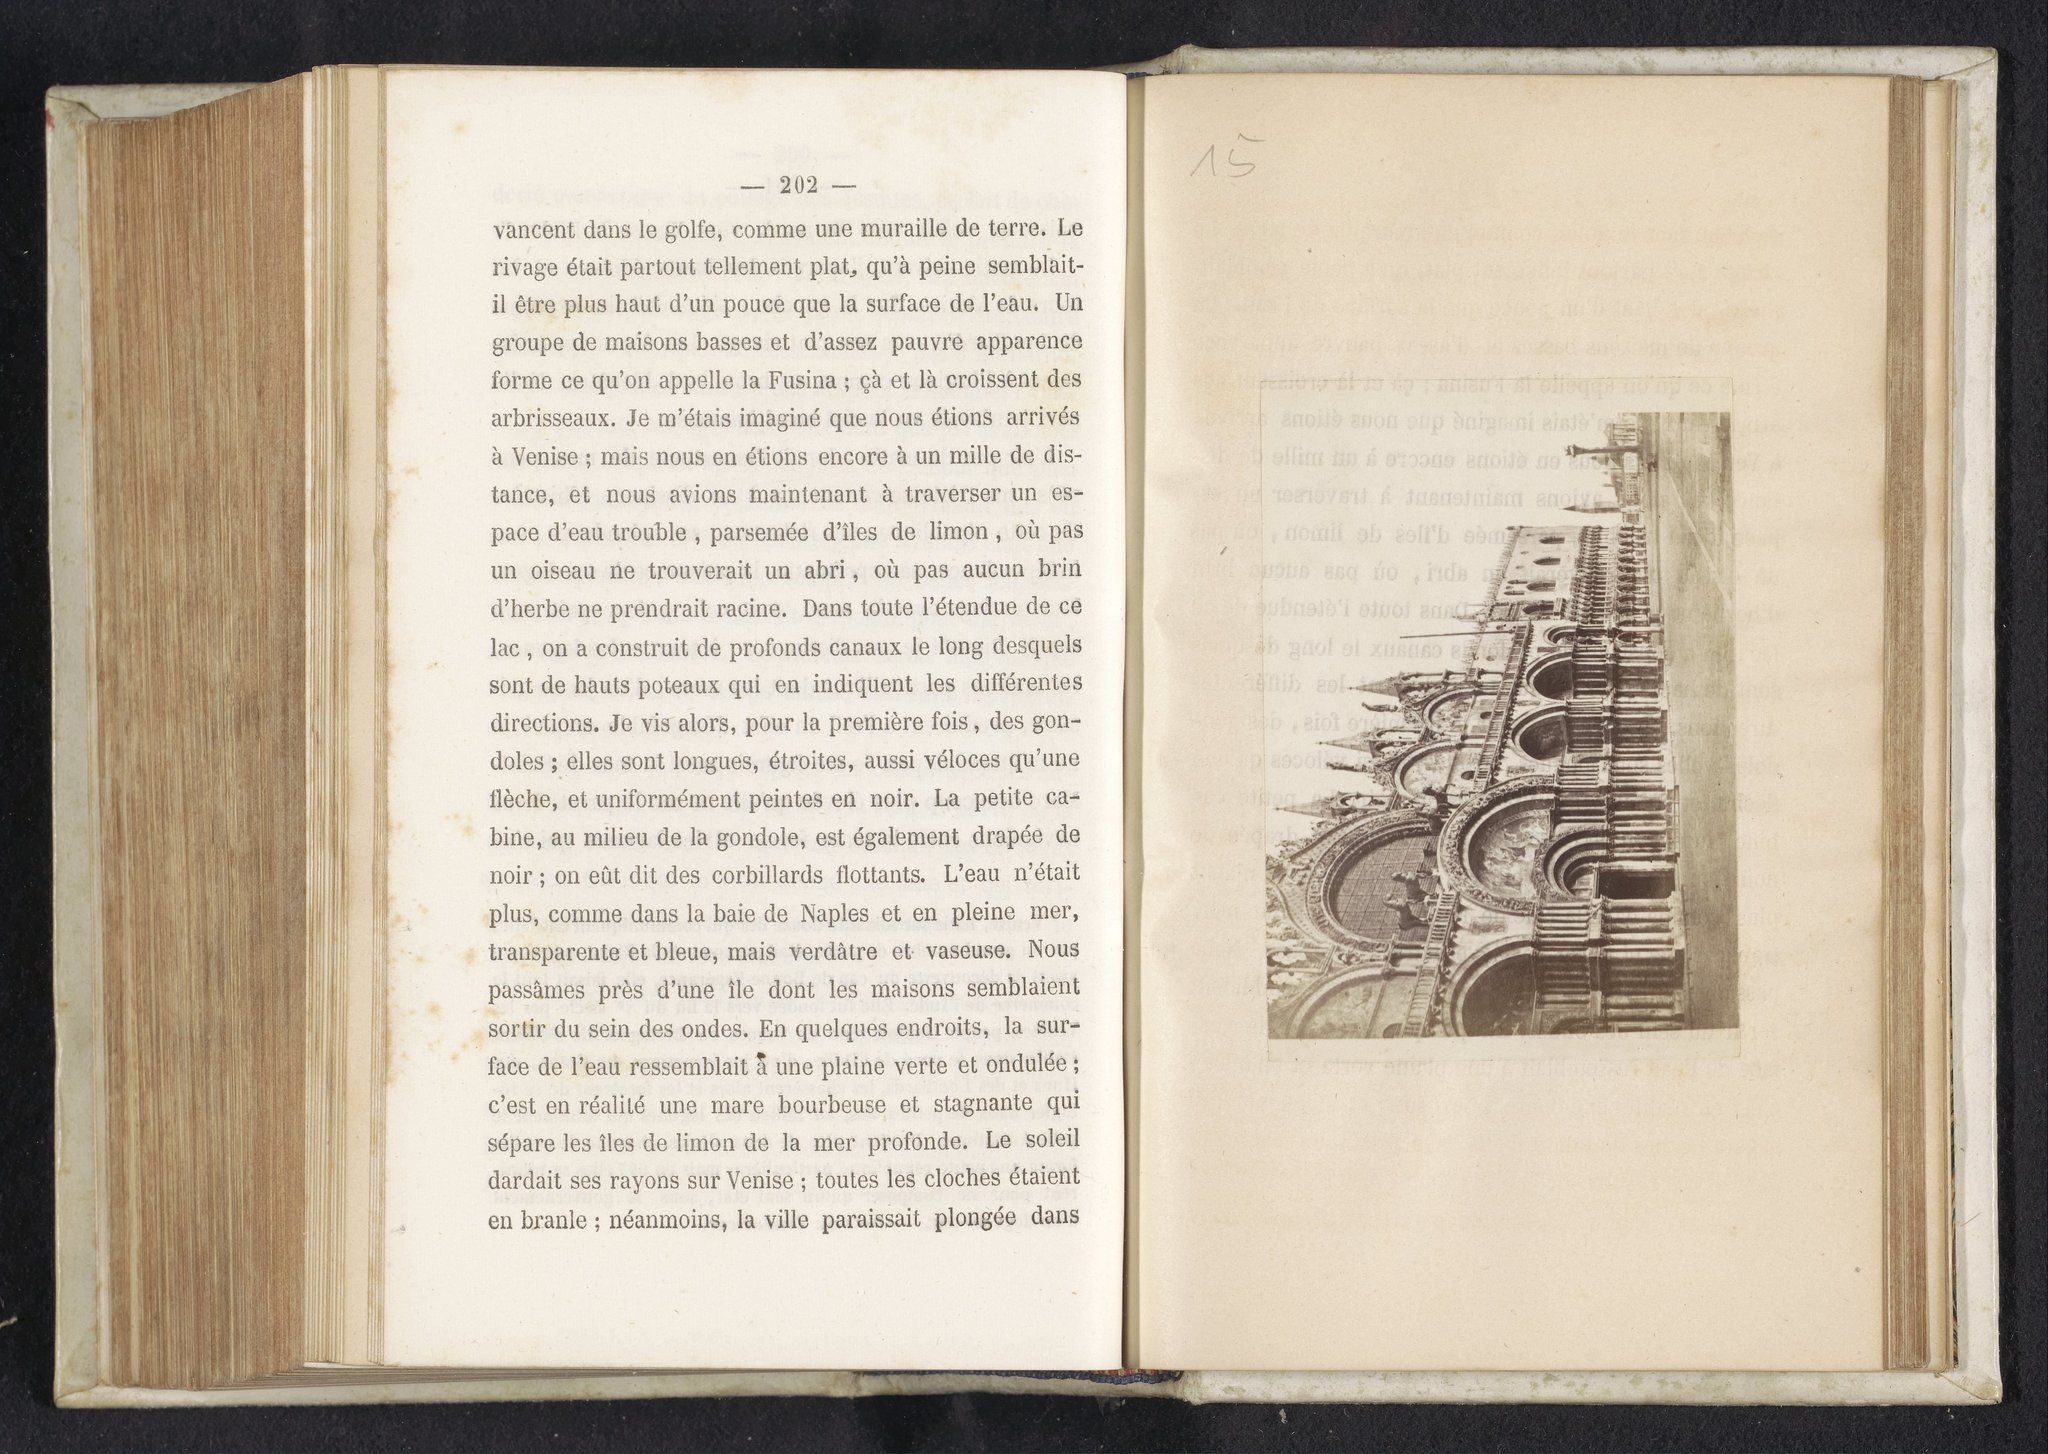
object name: photograph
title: Voorgevel van de Basiliek van San Marco te Venetië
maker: Anonymous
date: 1850-1860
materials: photographic support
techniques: albumen print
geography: venice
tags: church (exterior), façade (of house or building)